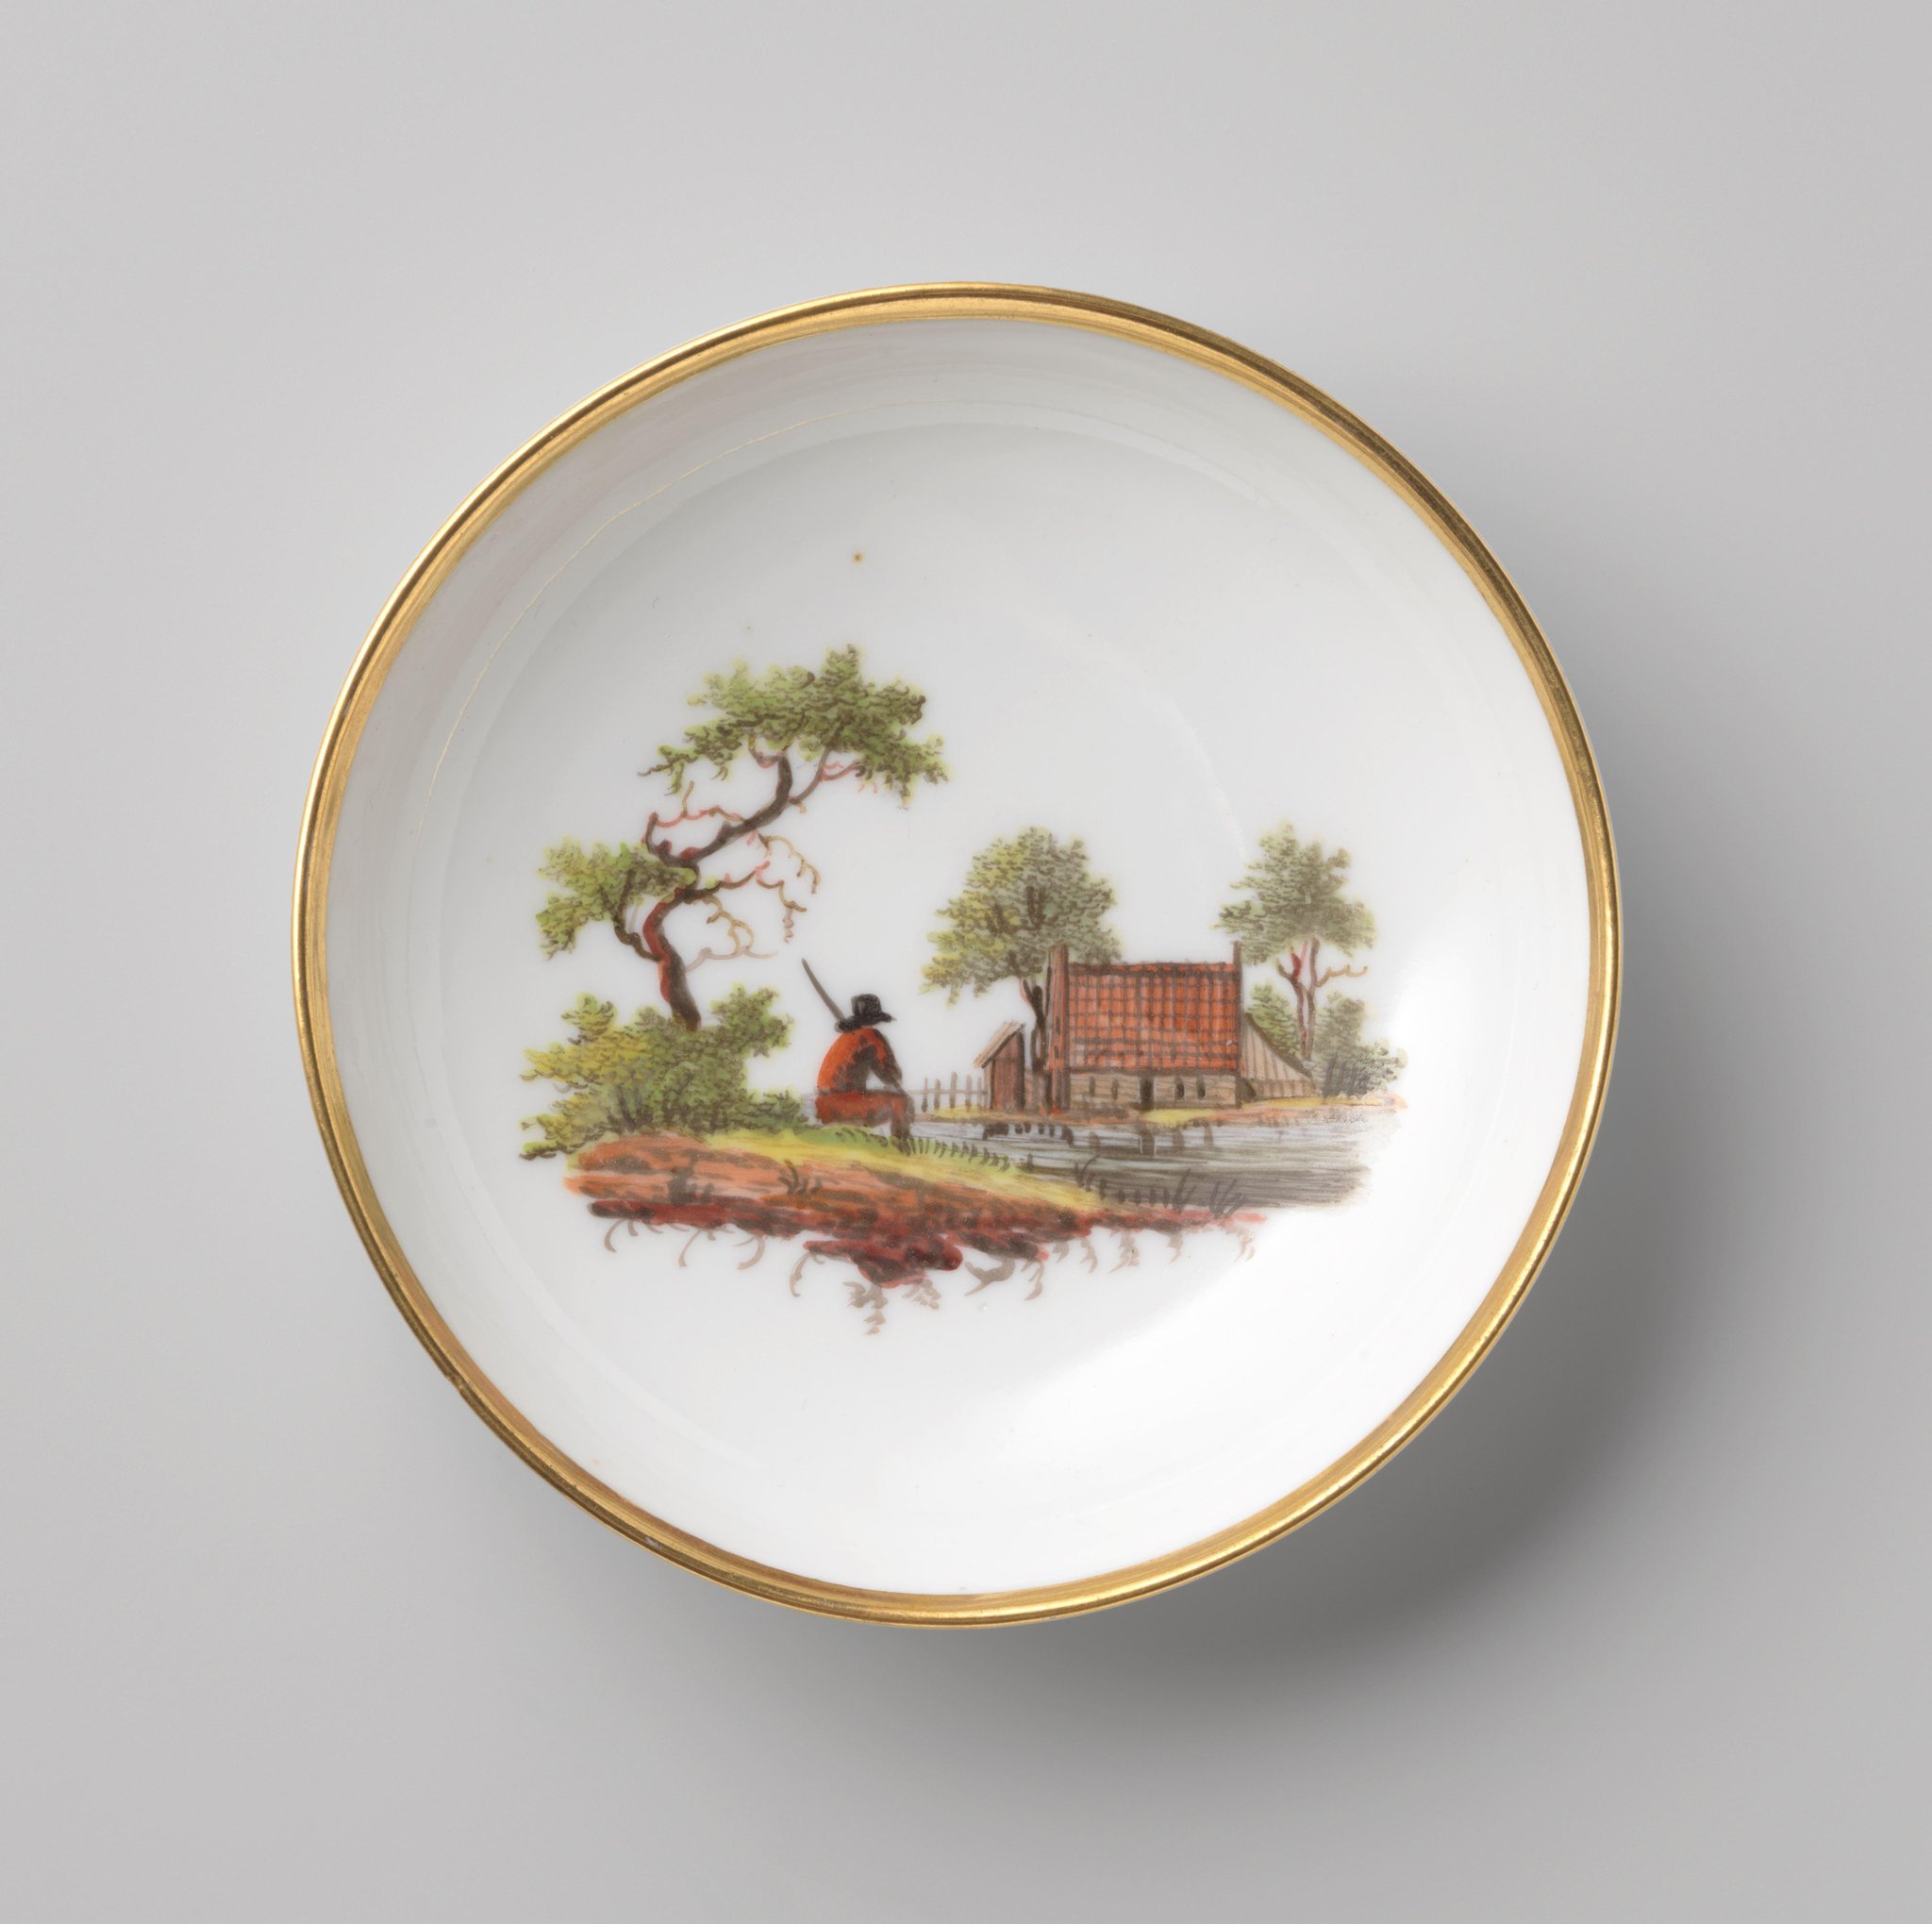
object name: kop en schotel, kop en schotel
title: Schotel met riviergezicht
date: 1809-1814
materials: porcelain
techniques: painted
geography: nieuwer-amstel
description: Schotel versierd met een zittende man in een veelkleurig landschap. Langs de randen een gouden rand. Gemerkt: Amstel.